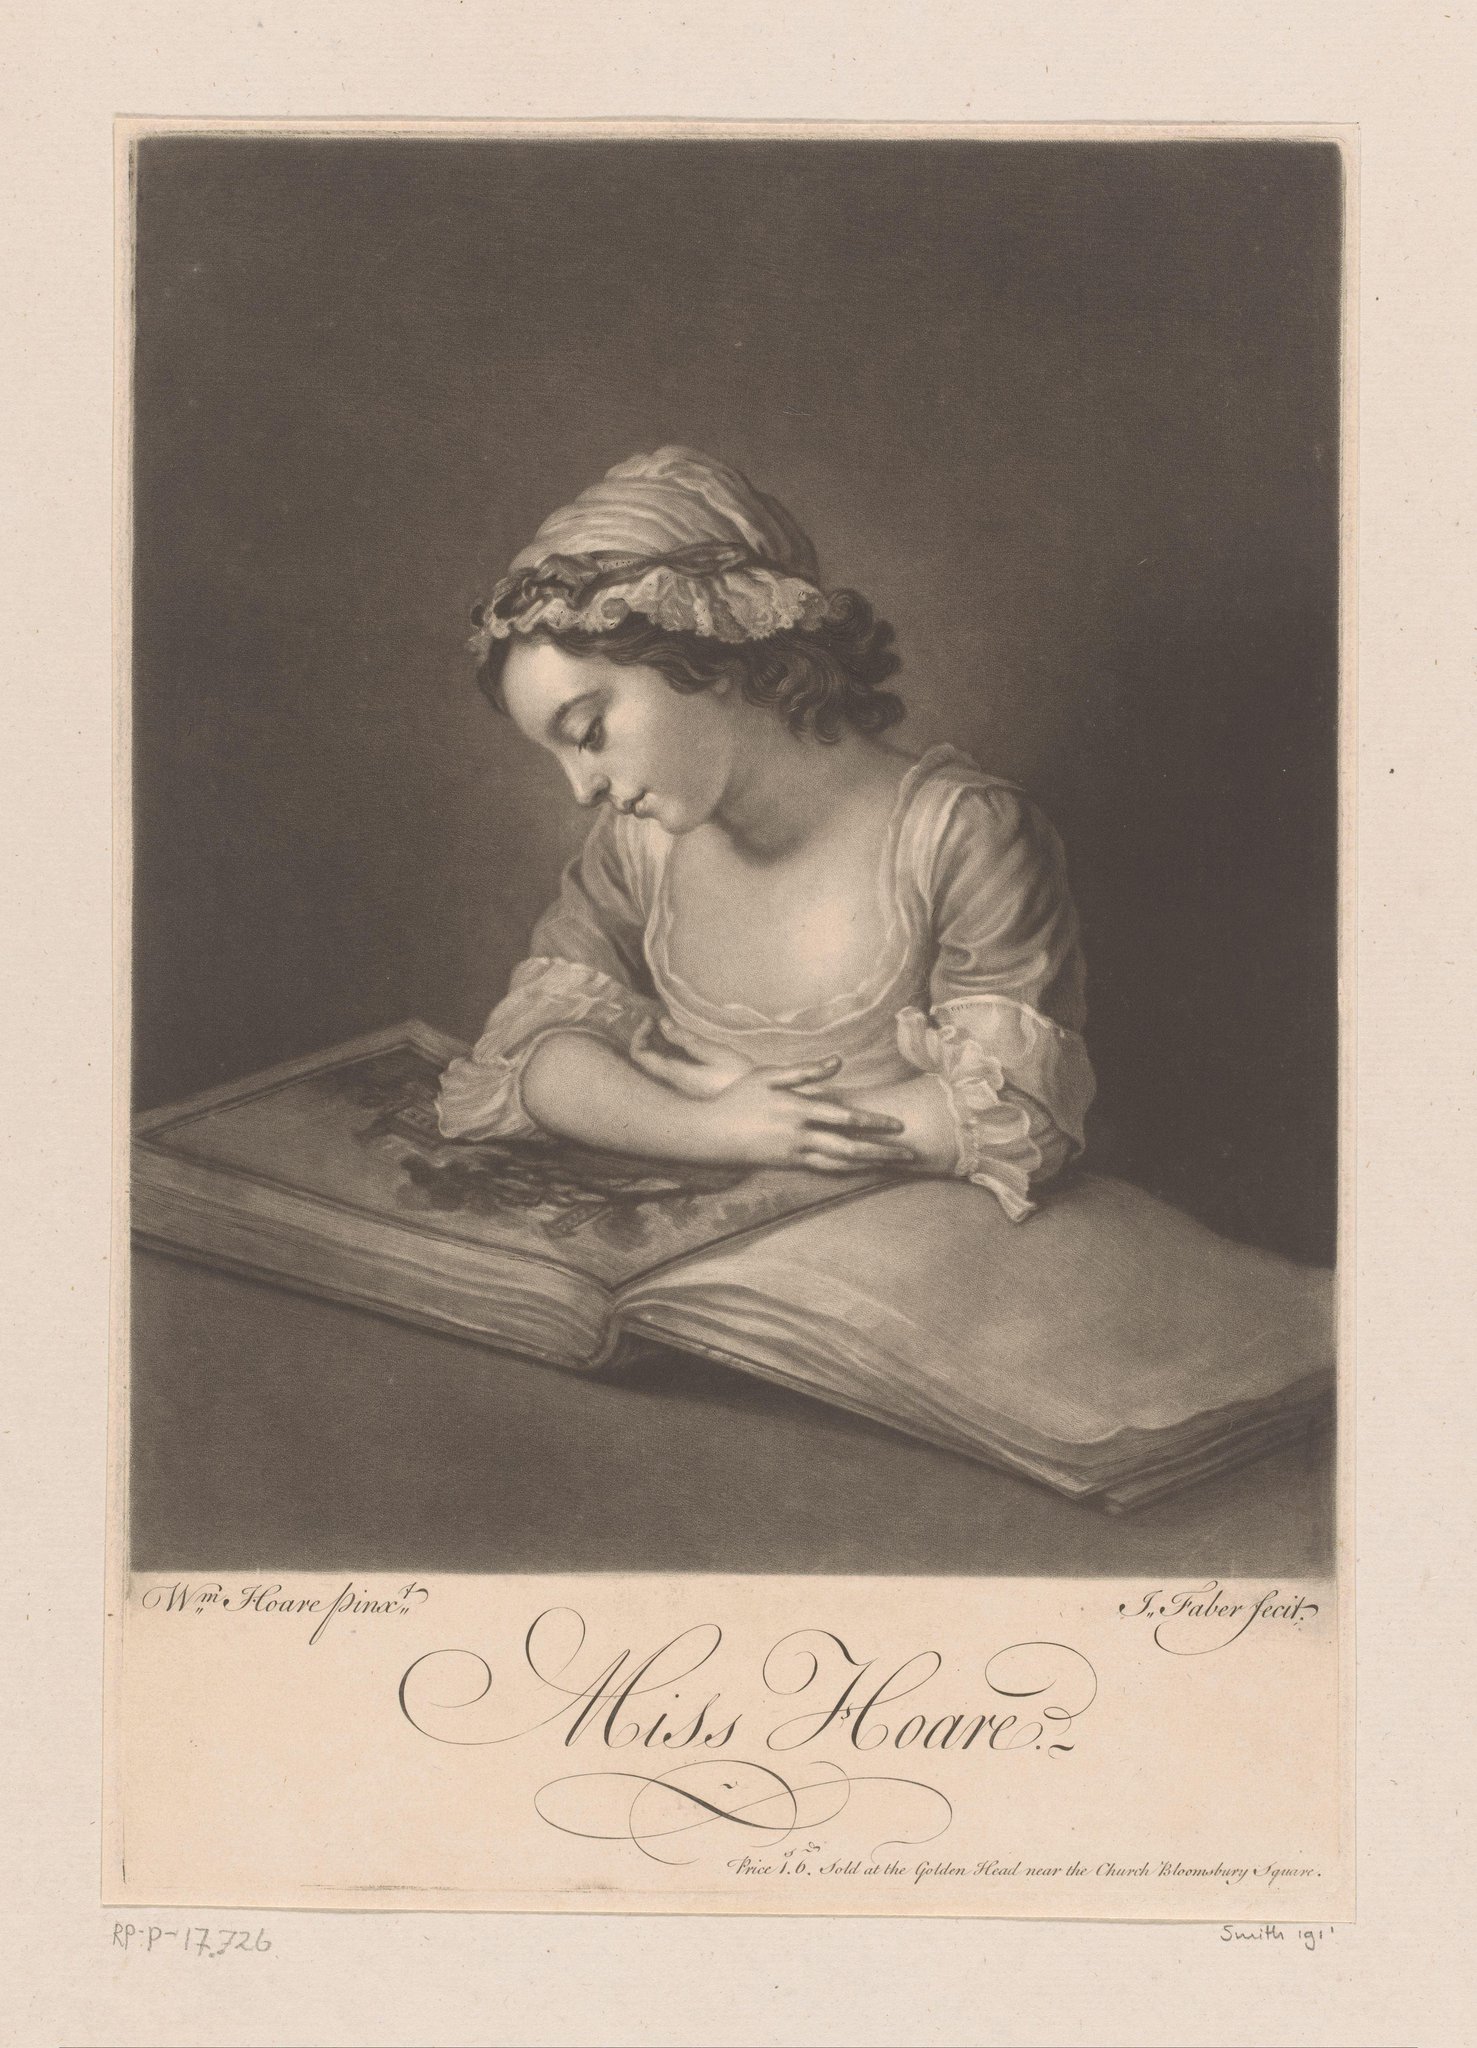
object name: print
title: Portret van Mary Hoare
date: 1735-1756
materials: paper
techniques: etching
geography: london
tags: historical persons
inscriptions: collector's mark: Lugt 240